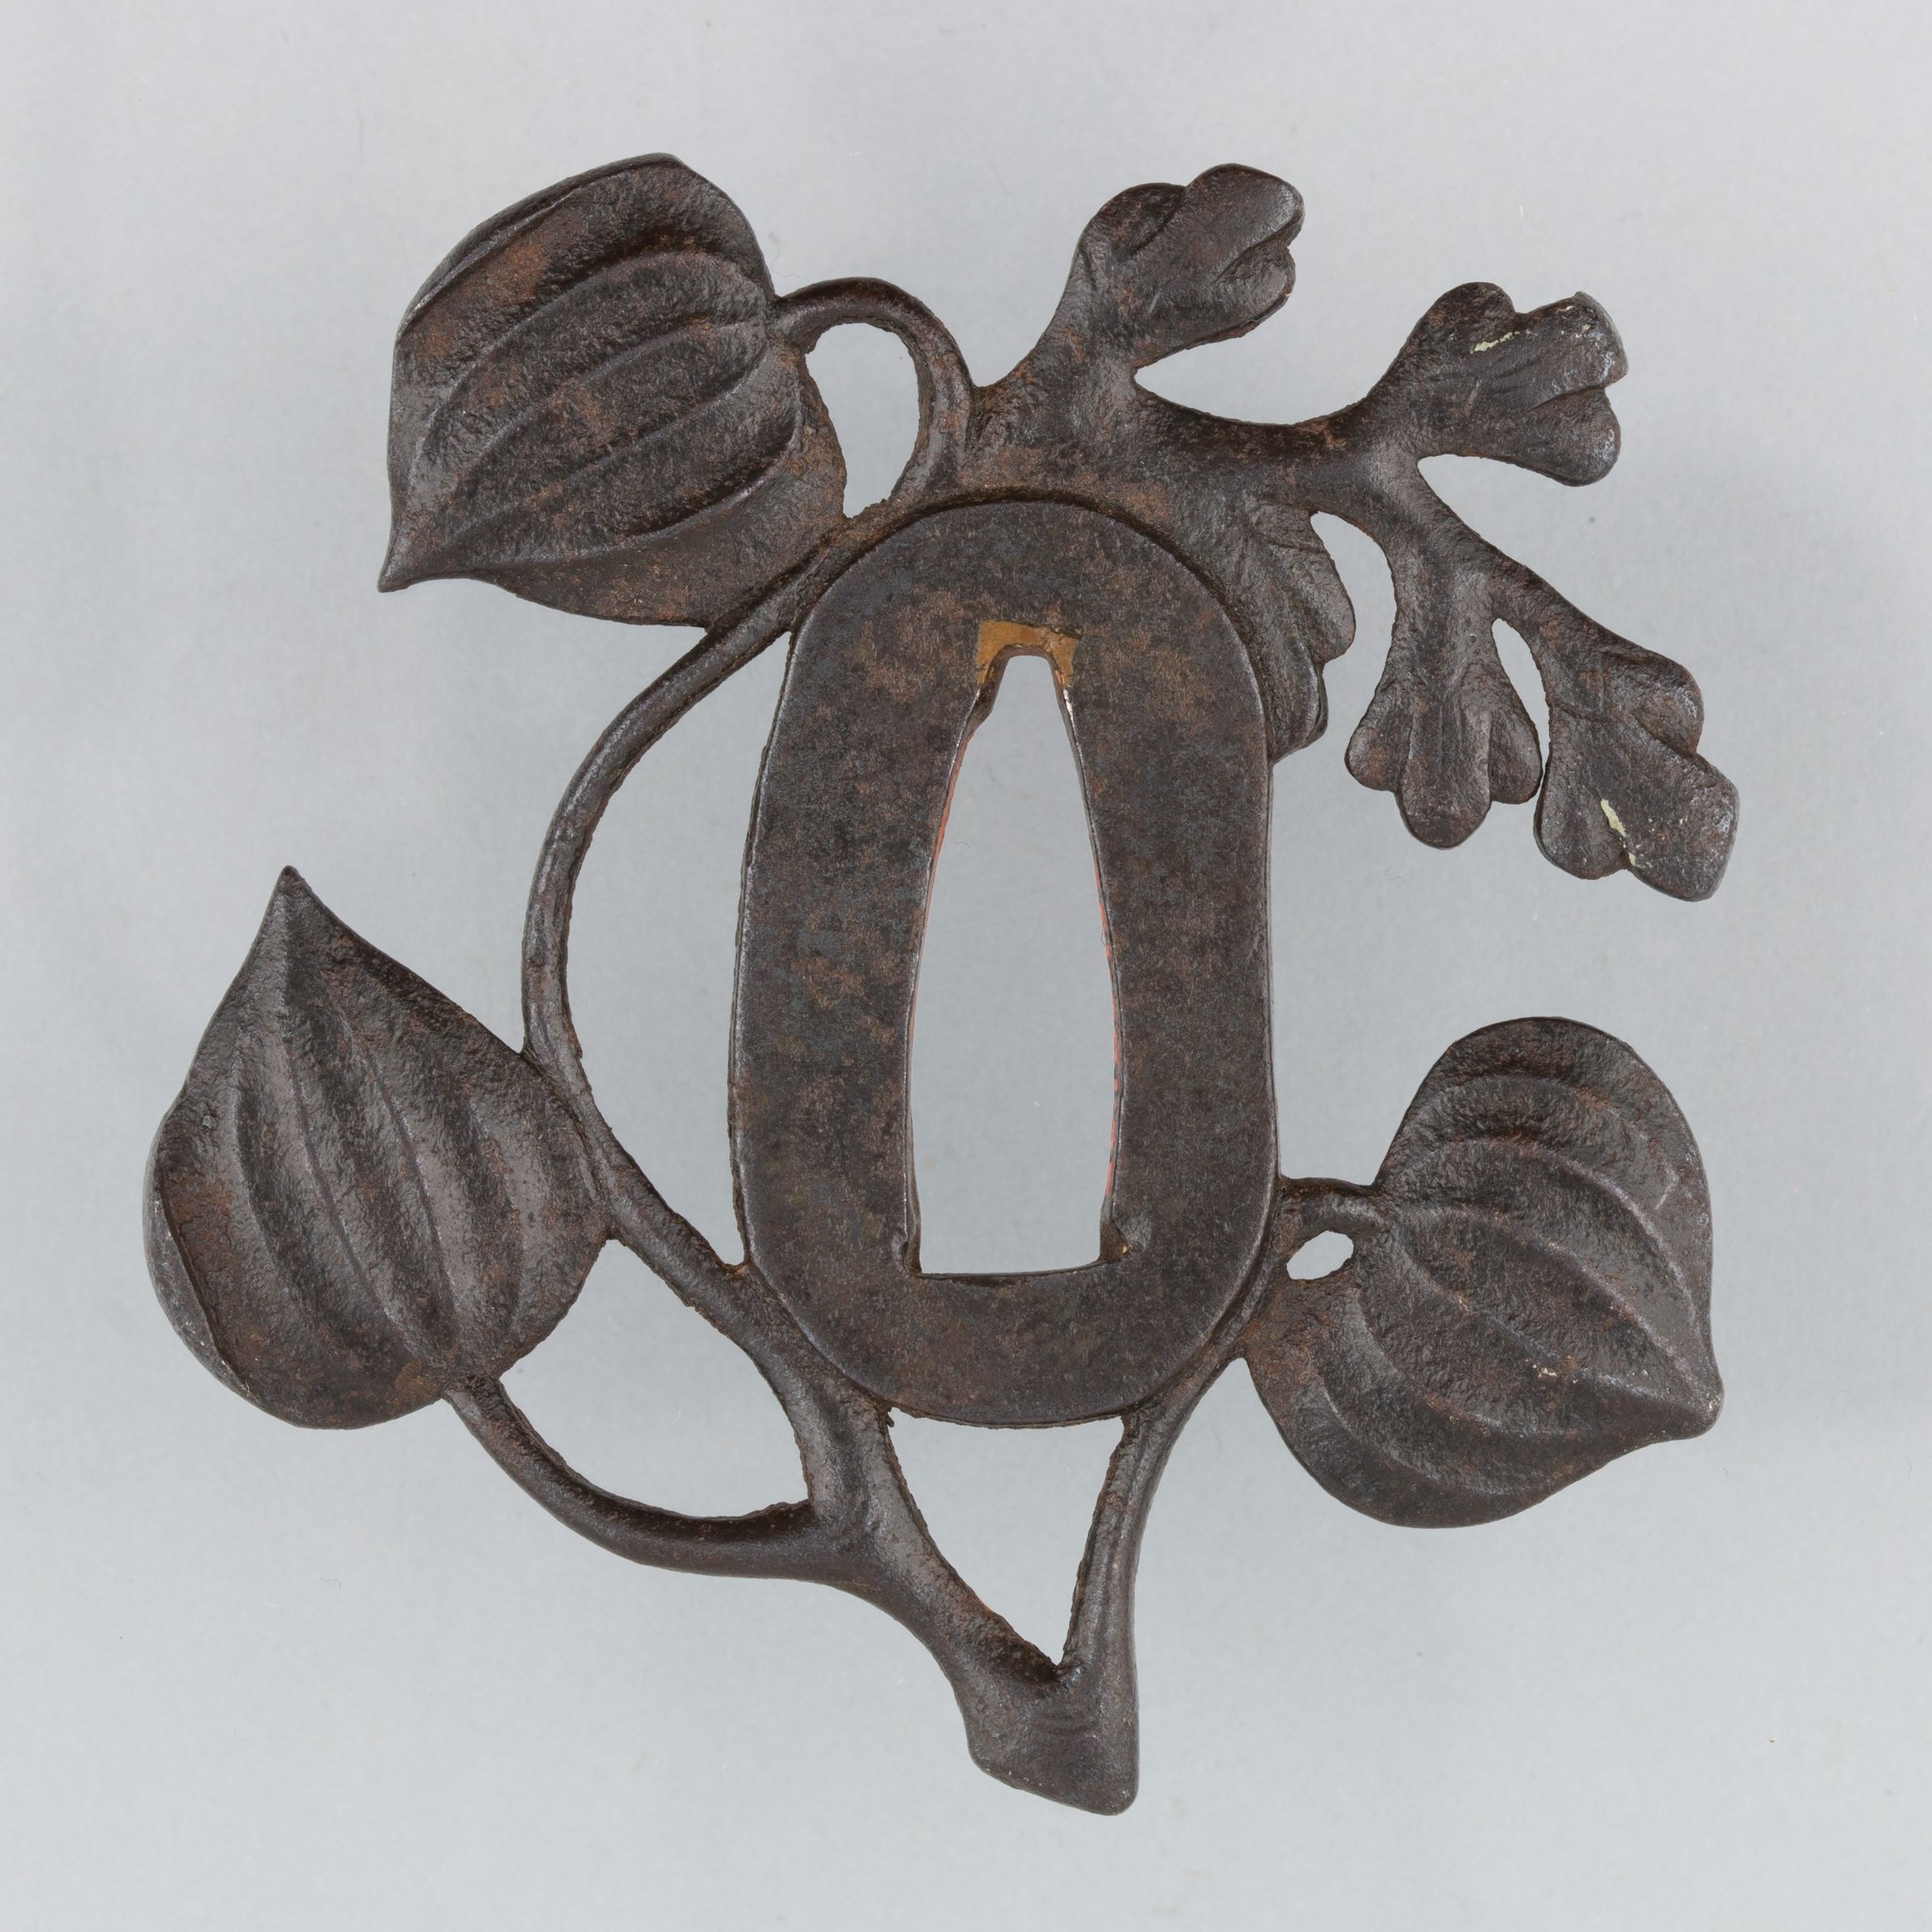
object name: sword guard tsuba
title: Sword Guard (Tsuba)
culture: japanese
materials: copper, iron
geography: japan